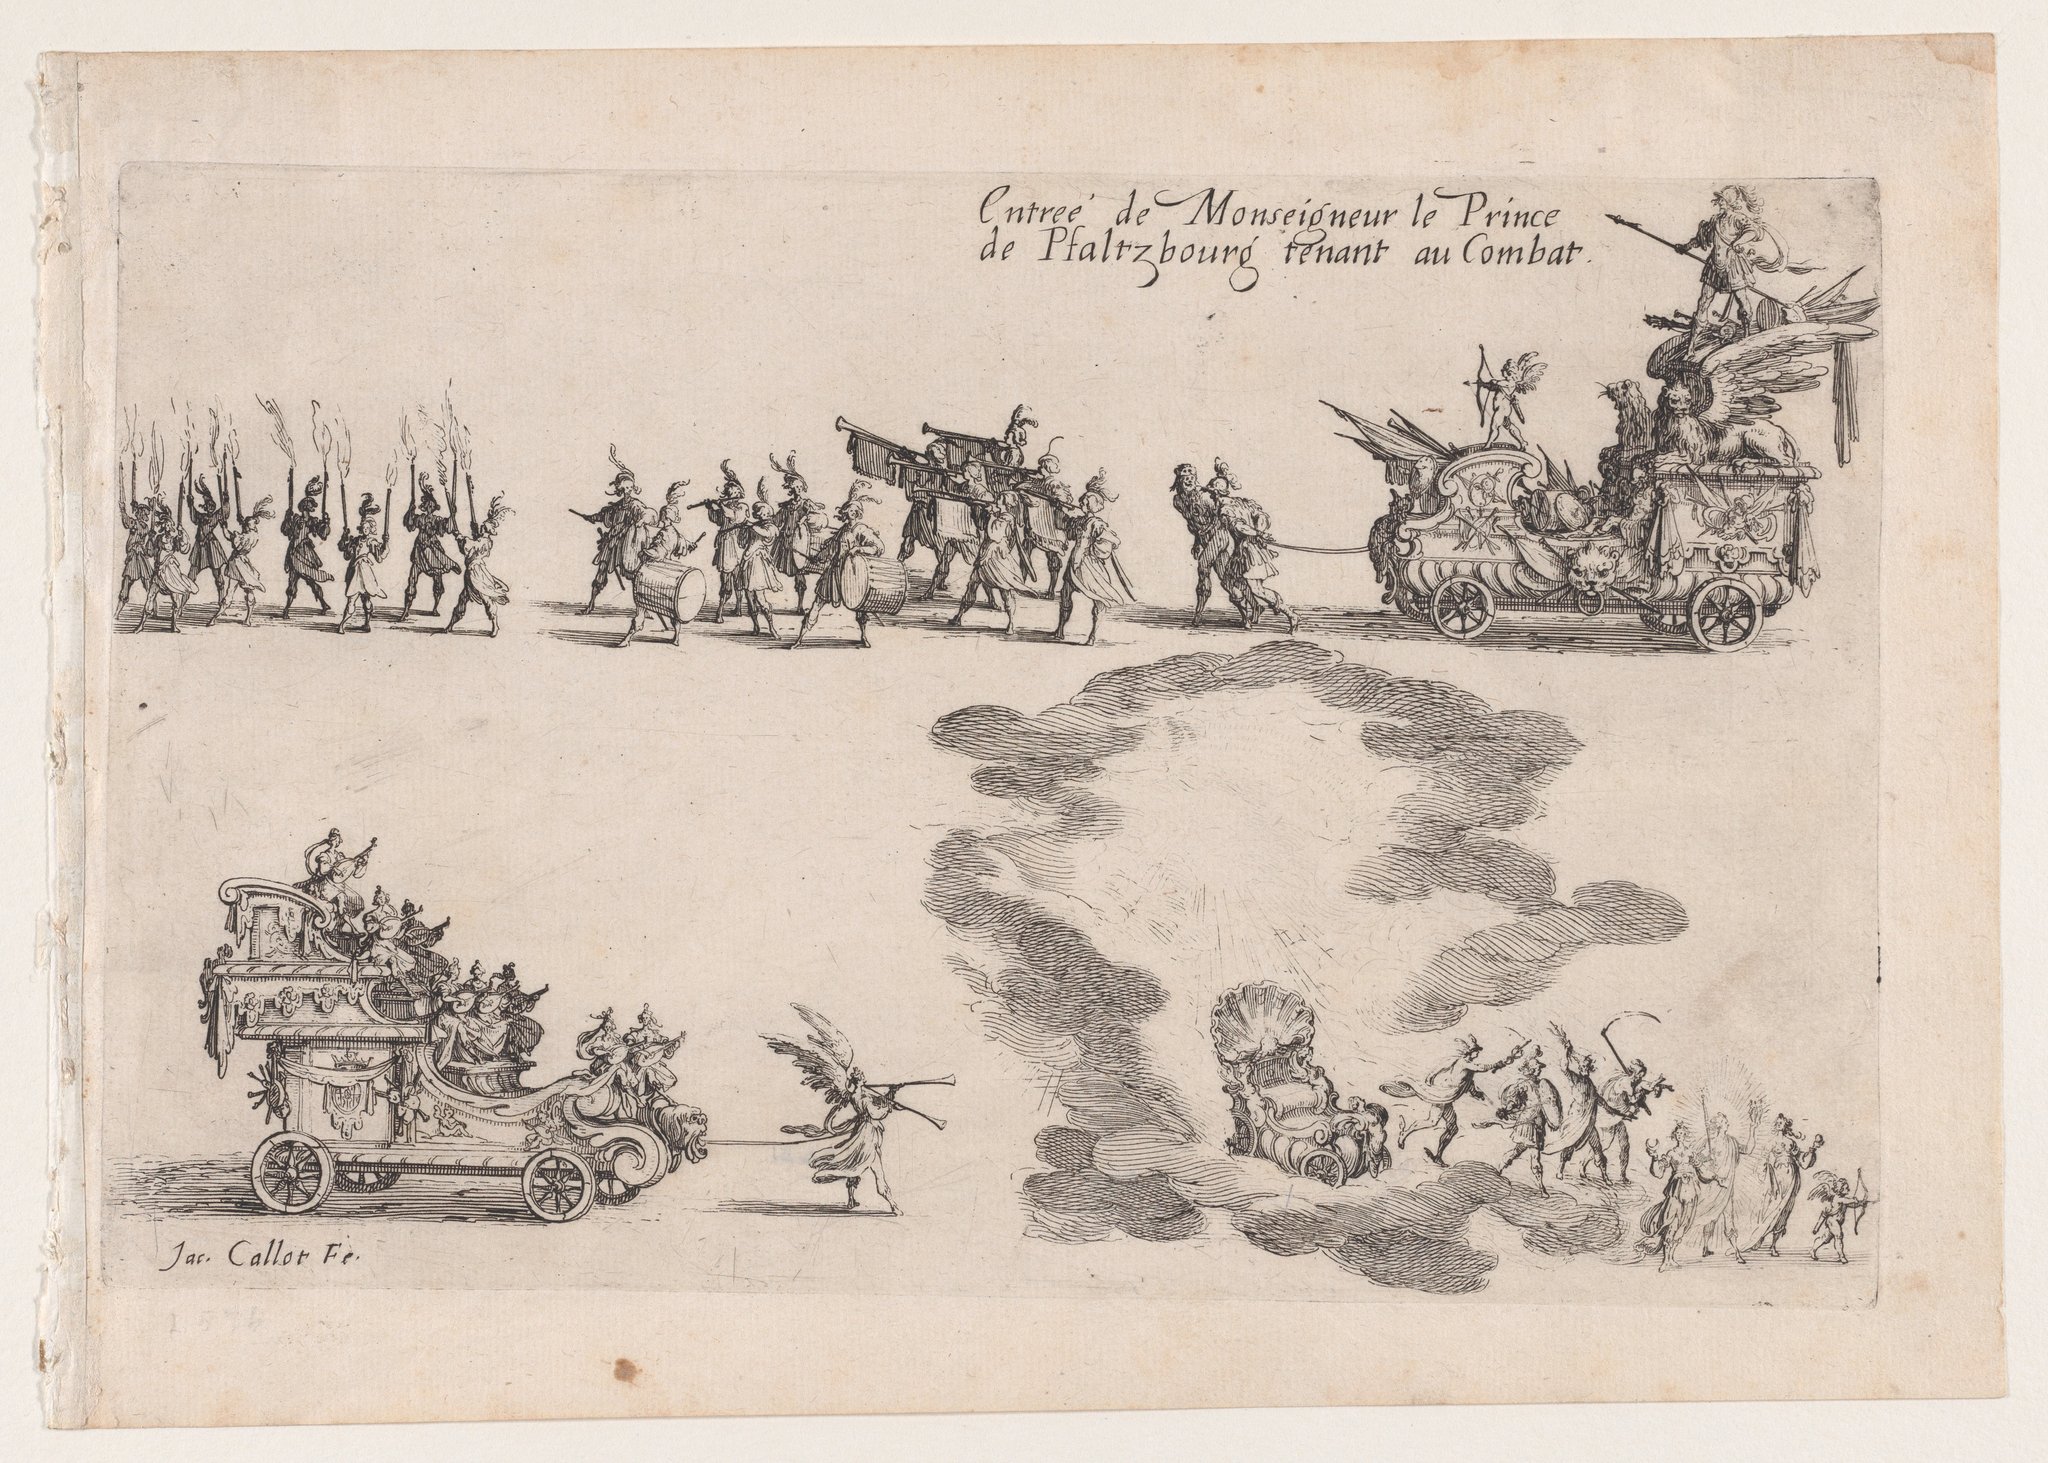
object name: print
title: Entrée du Prince de Pfalzbourg (Entrance of the Prince of Pflazbourg), from Le Combat a la Barrière in the Palace at Nancy by Henri Humbert, printed by Sebastien Phillipe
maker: jacques callot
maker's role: artist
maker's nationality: french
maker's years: 1592-1635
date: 1627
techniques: etching